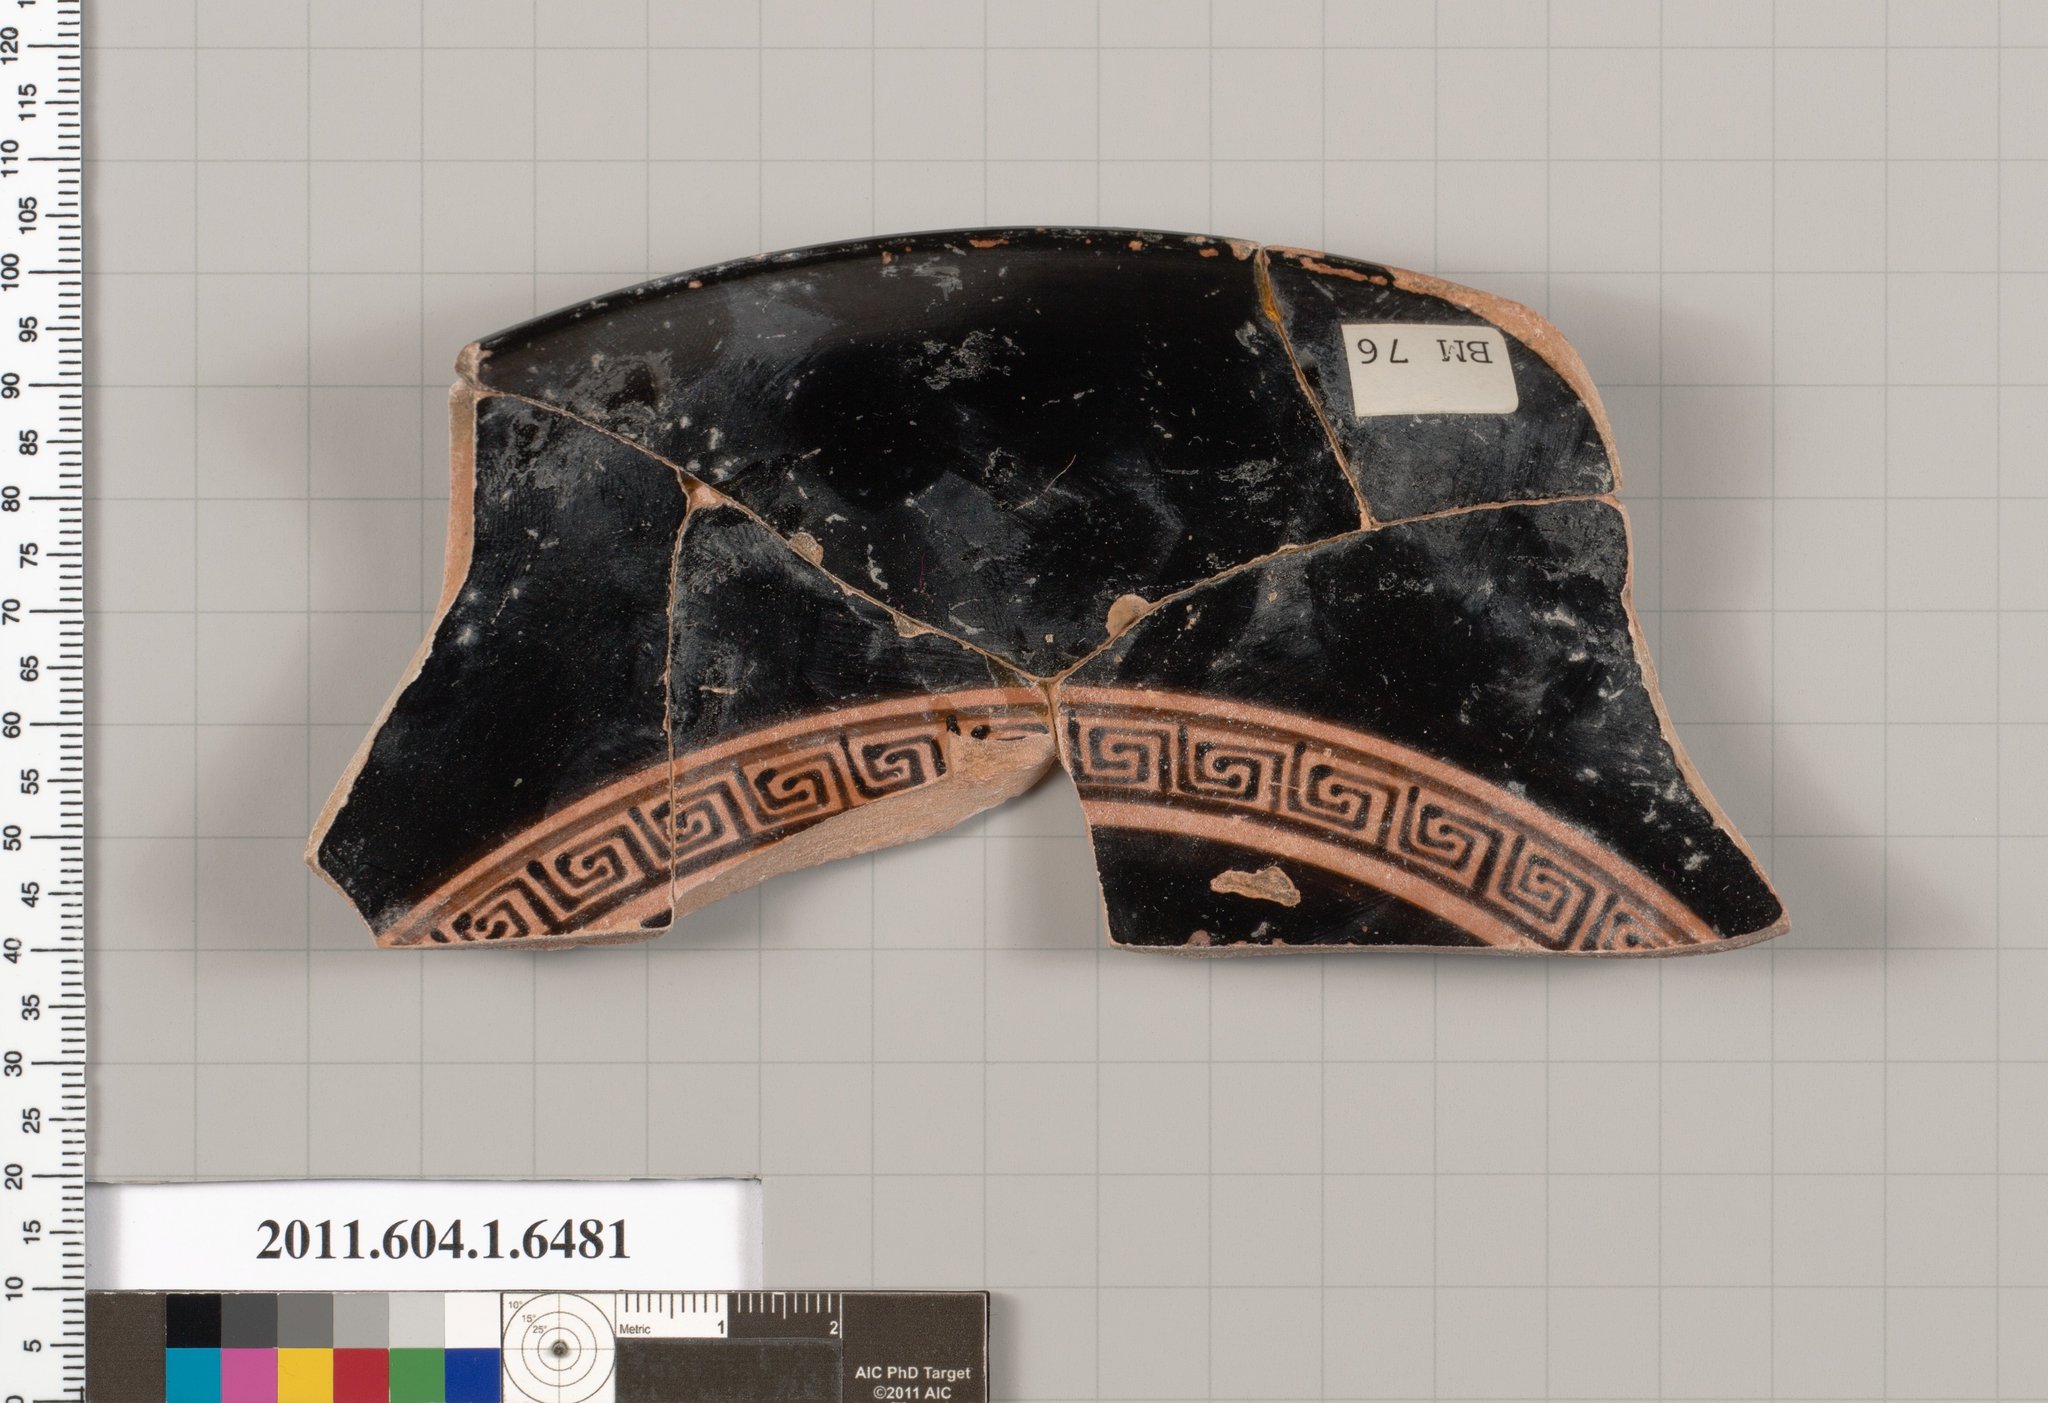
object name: kylix fragment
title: Terracotta fragment of a kylix (drinking cup)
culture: greek, attic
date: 490-480 BCE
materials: terracotta